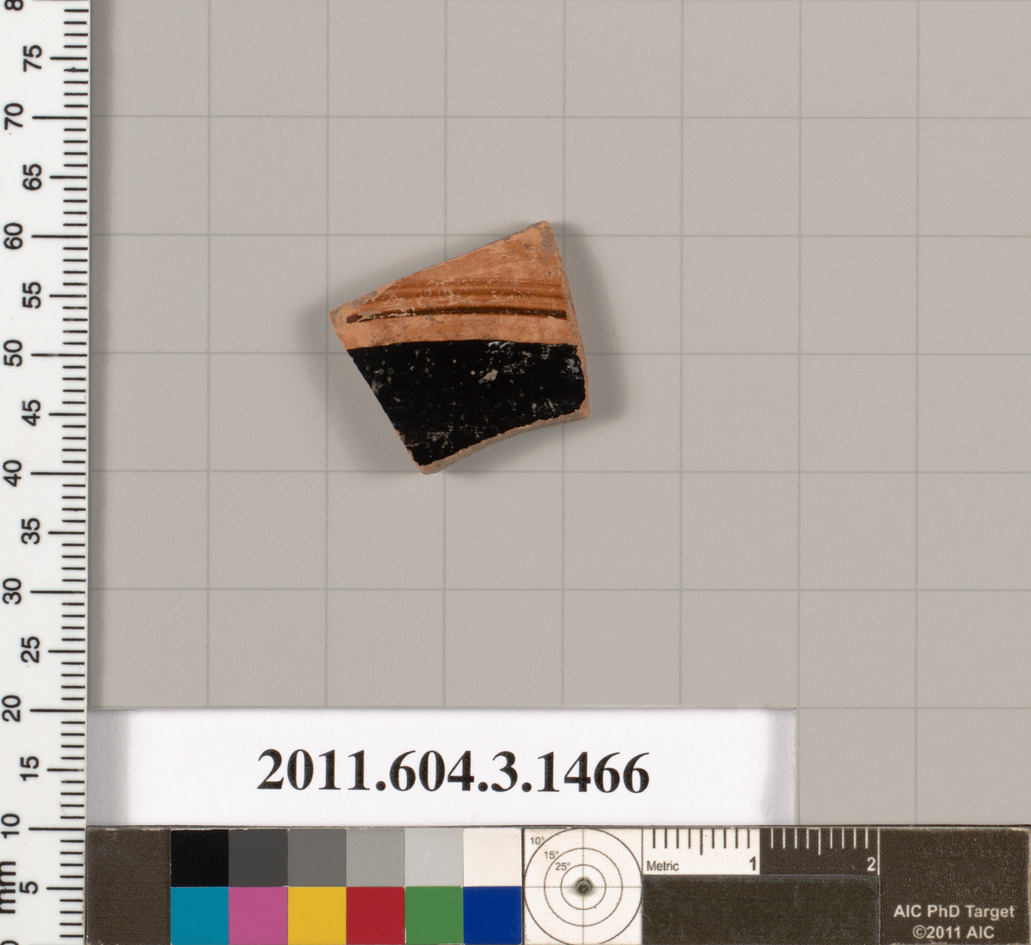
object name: skyphos fragment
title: Terracotta fragment of a skyphos (deep drinking cup)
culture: greek, attic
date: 600-401 BCE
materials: terracotta